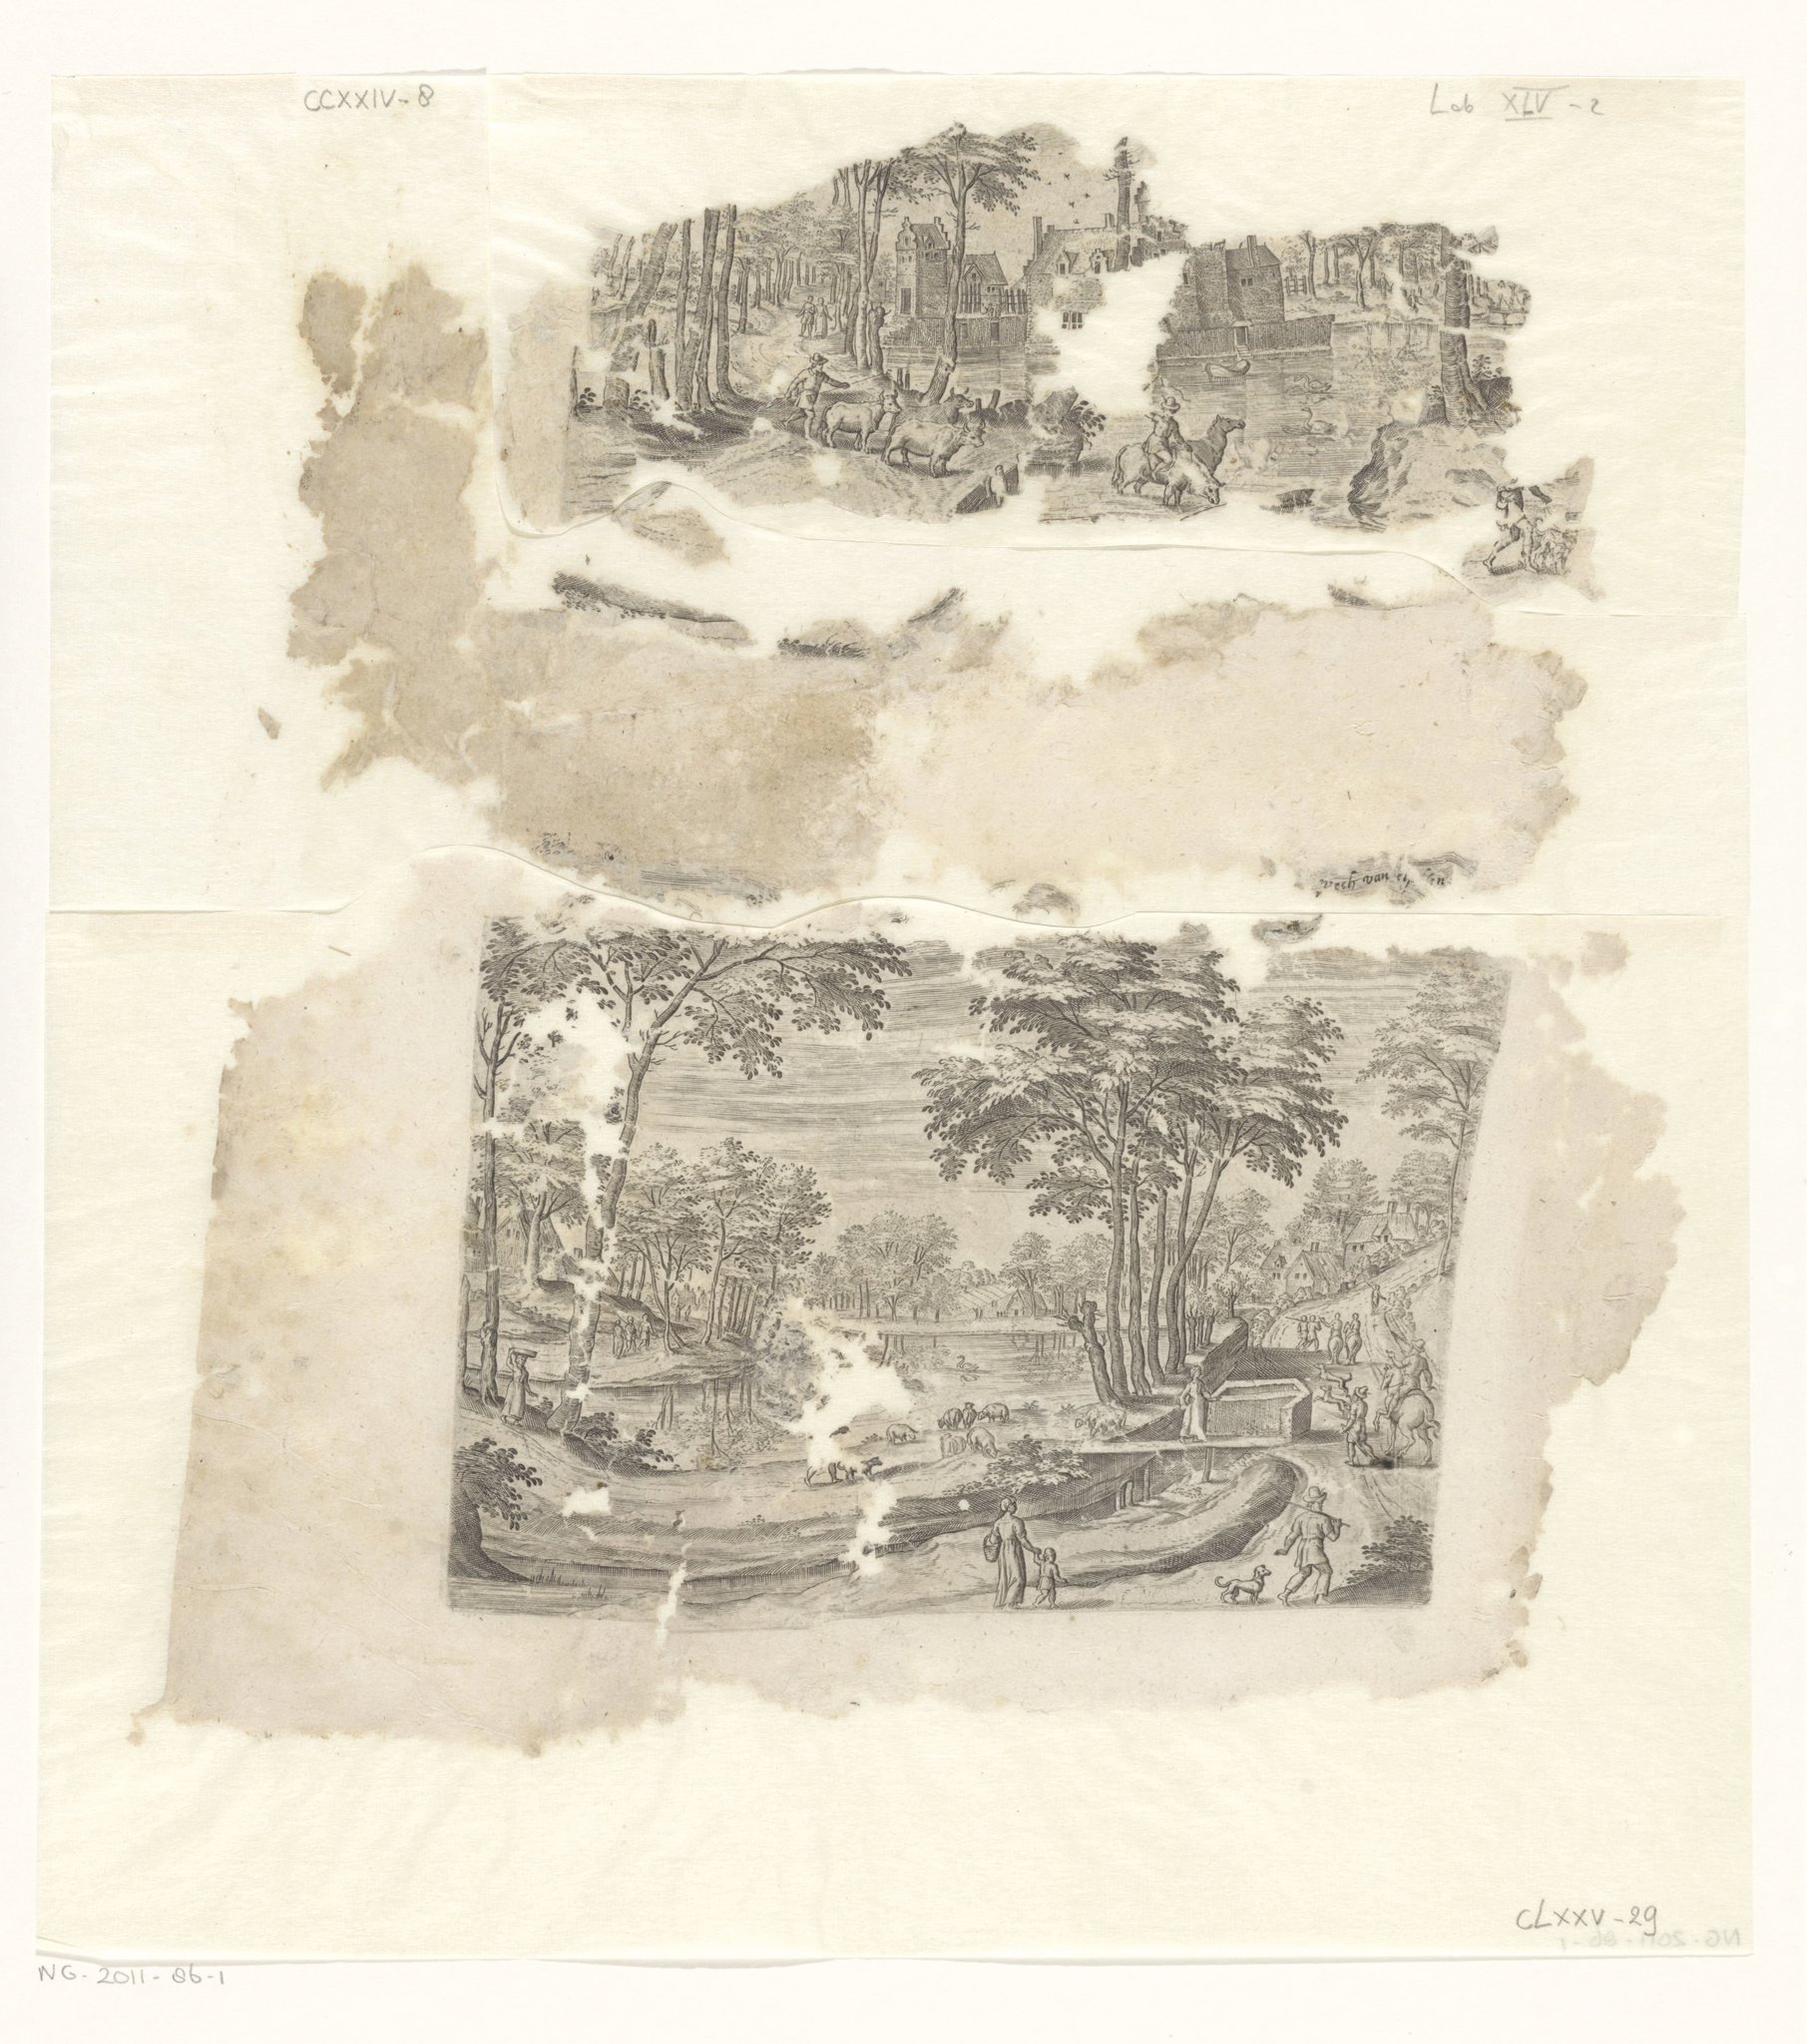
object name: print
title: Landschappen in de omgeving van Brussel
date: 1575-1580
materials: paper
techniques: engraving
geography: southern netherlands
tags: city-view, and landscape with man-made constructions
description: Prenten zijn onderdeel van een serie van 24. De prenten in de Nova Zembla collectie zijn tijdens een expeditie van Willem Barendsz en Jacob van Heemskerk in 1596-1597 noodgedwongen in het winterkamp, het ‘Behouden Huis’, op het eiland achtergelaten. De prenten waren in één of meerdere stapels als handelswaar meegenomen vanuit Amsterdam. Bijna drie eeuwen later, in 1871, keerde de Noor Elling Carlsen terug naar Nova Zembla en vond daar de restanten van het ‘Behouden Huis, inclusief een groot deel van de inventaris. Een deel van de prenten, in de vorm van aaneengekoekte kluiten, werd toen ook teruggevonden. De papierkluiten waren soms op meerdere plekken gebroken. Tussen 1975-1979 zijn de prenten van elkaar gescheiden. Dit leverde in totaal ca. 1000 fragmenten van ca. 400 afdrukken van ca. 150 verschillende prenten op. Voor zover mogelijk zijn de fragmenten samengevoegd en zijn de prenten gereconstrueerd.